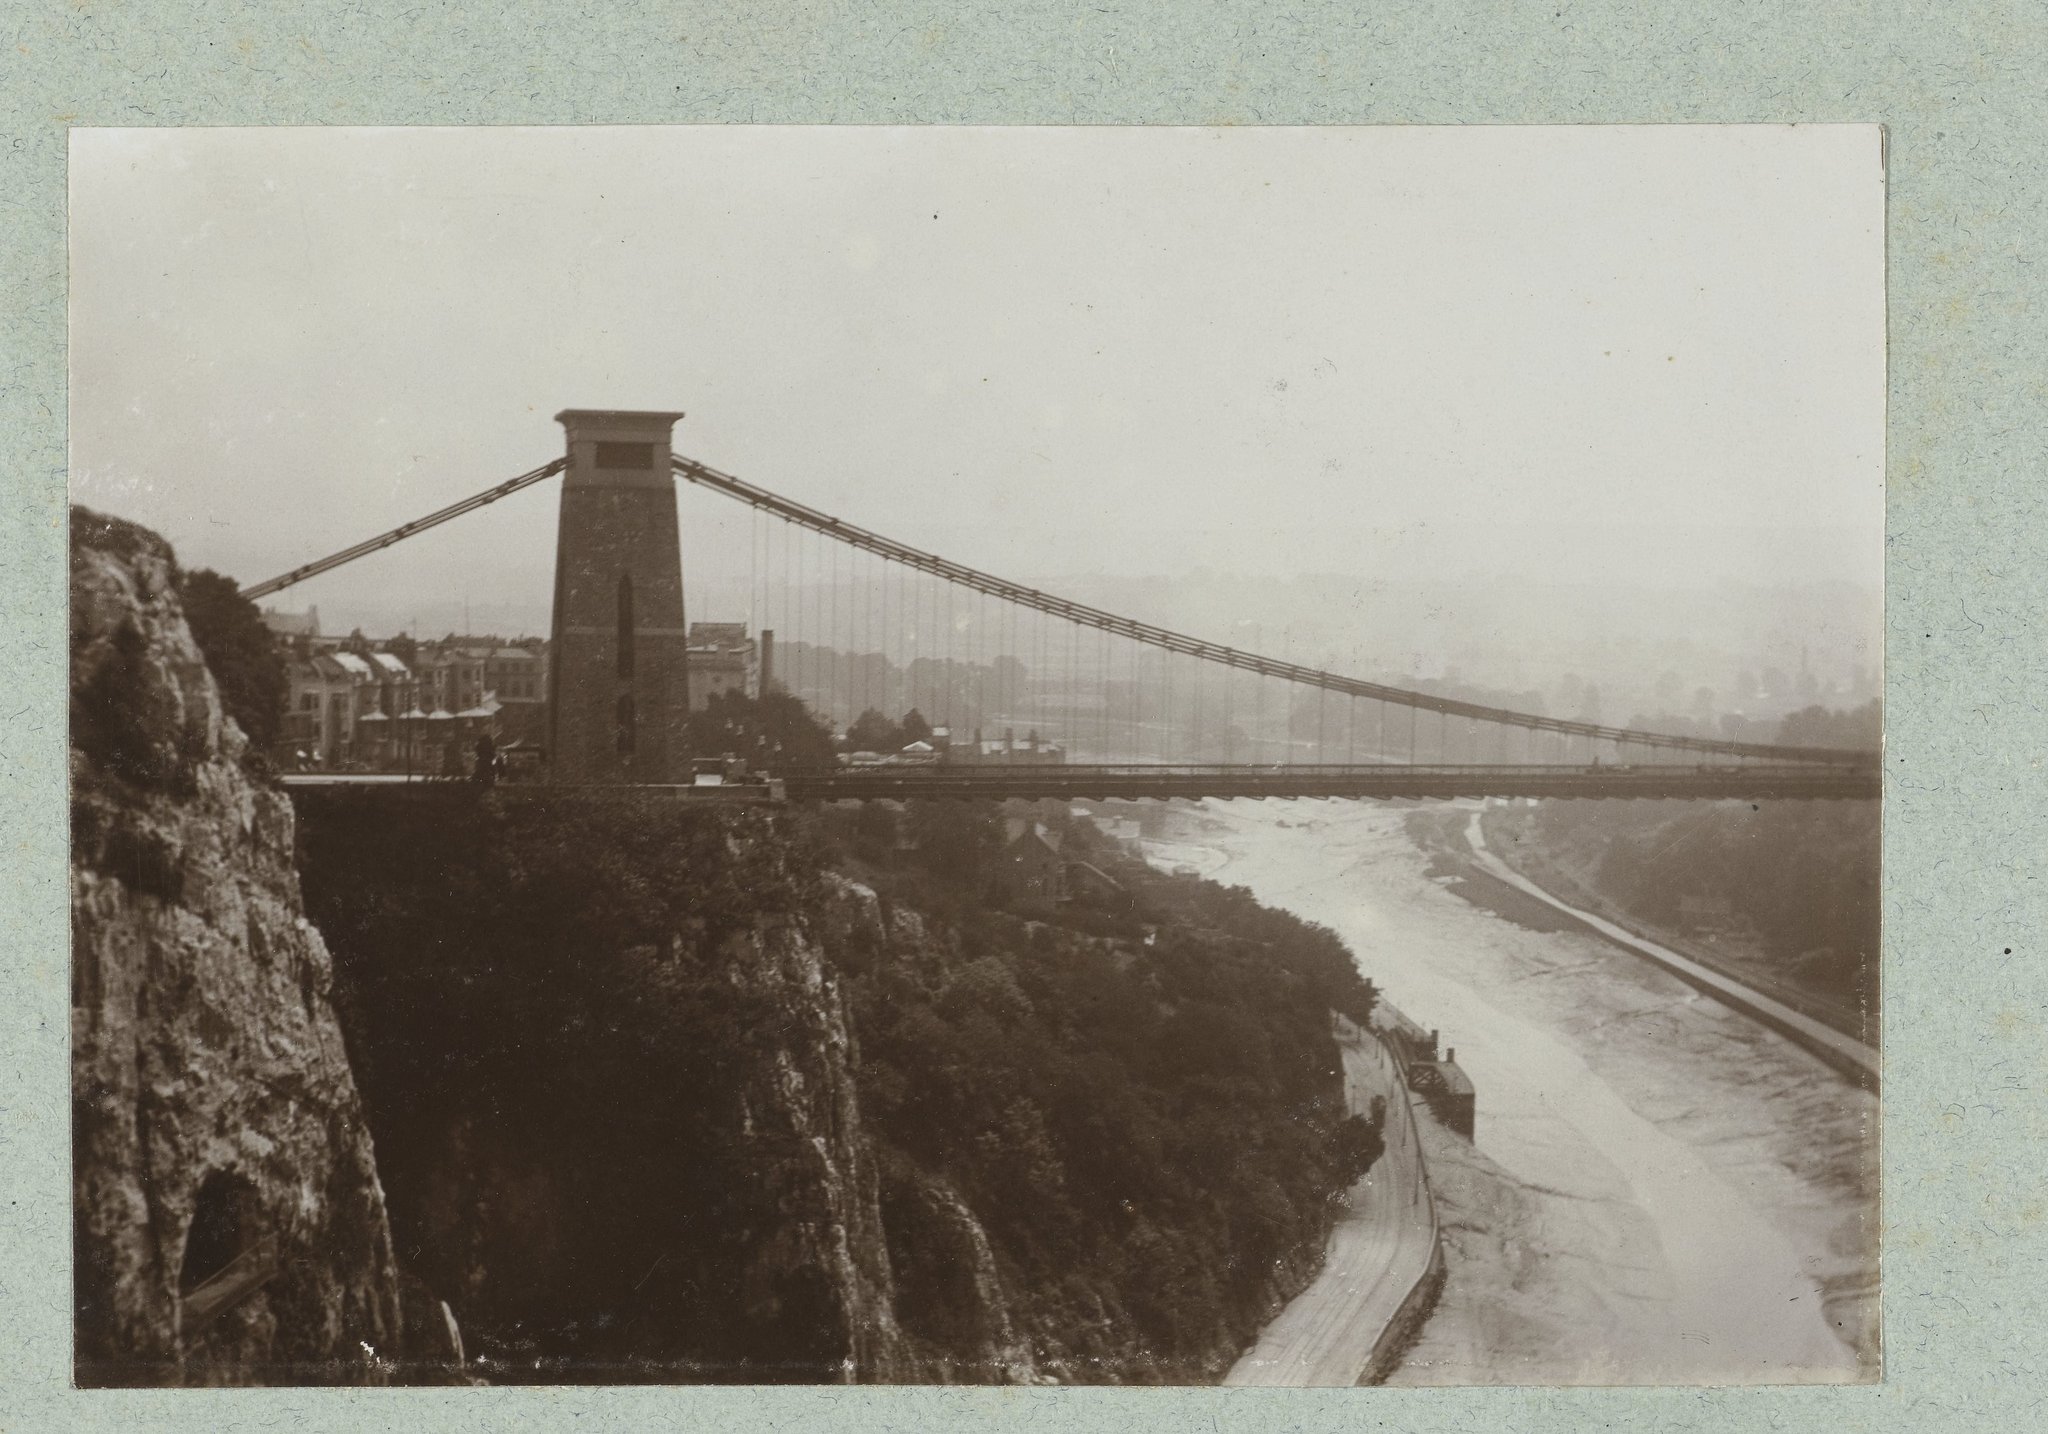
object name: photograph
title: De Clifton Suspension Bridge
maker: frits freerks fontein fz.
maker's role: fotograaf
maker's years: 1882-1928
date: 1901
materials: cardboard, paper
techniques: gelatin silver print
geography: netherlands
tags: bristol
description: De Clifton Suspension Bridge ( hangbrug) over de kloof waarin de rivier de Avon loopt bij Bristol. Foto uit album 'Photographieën".